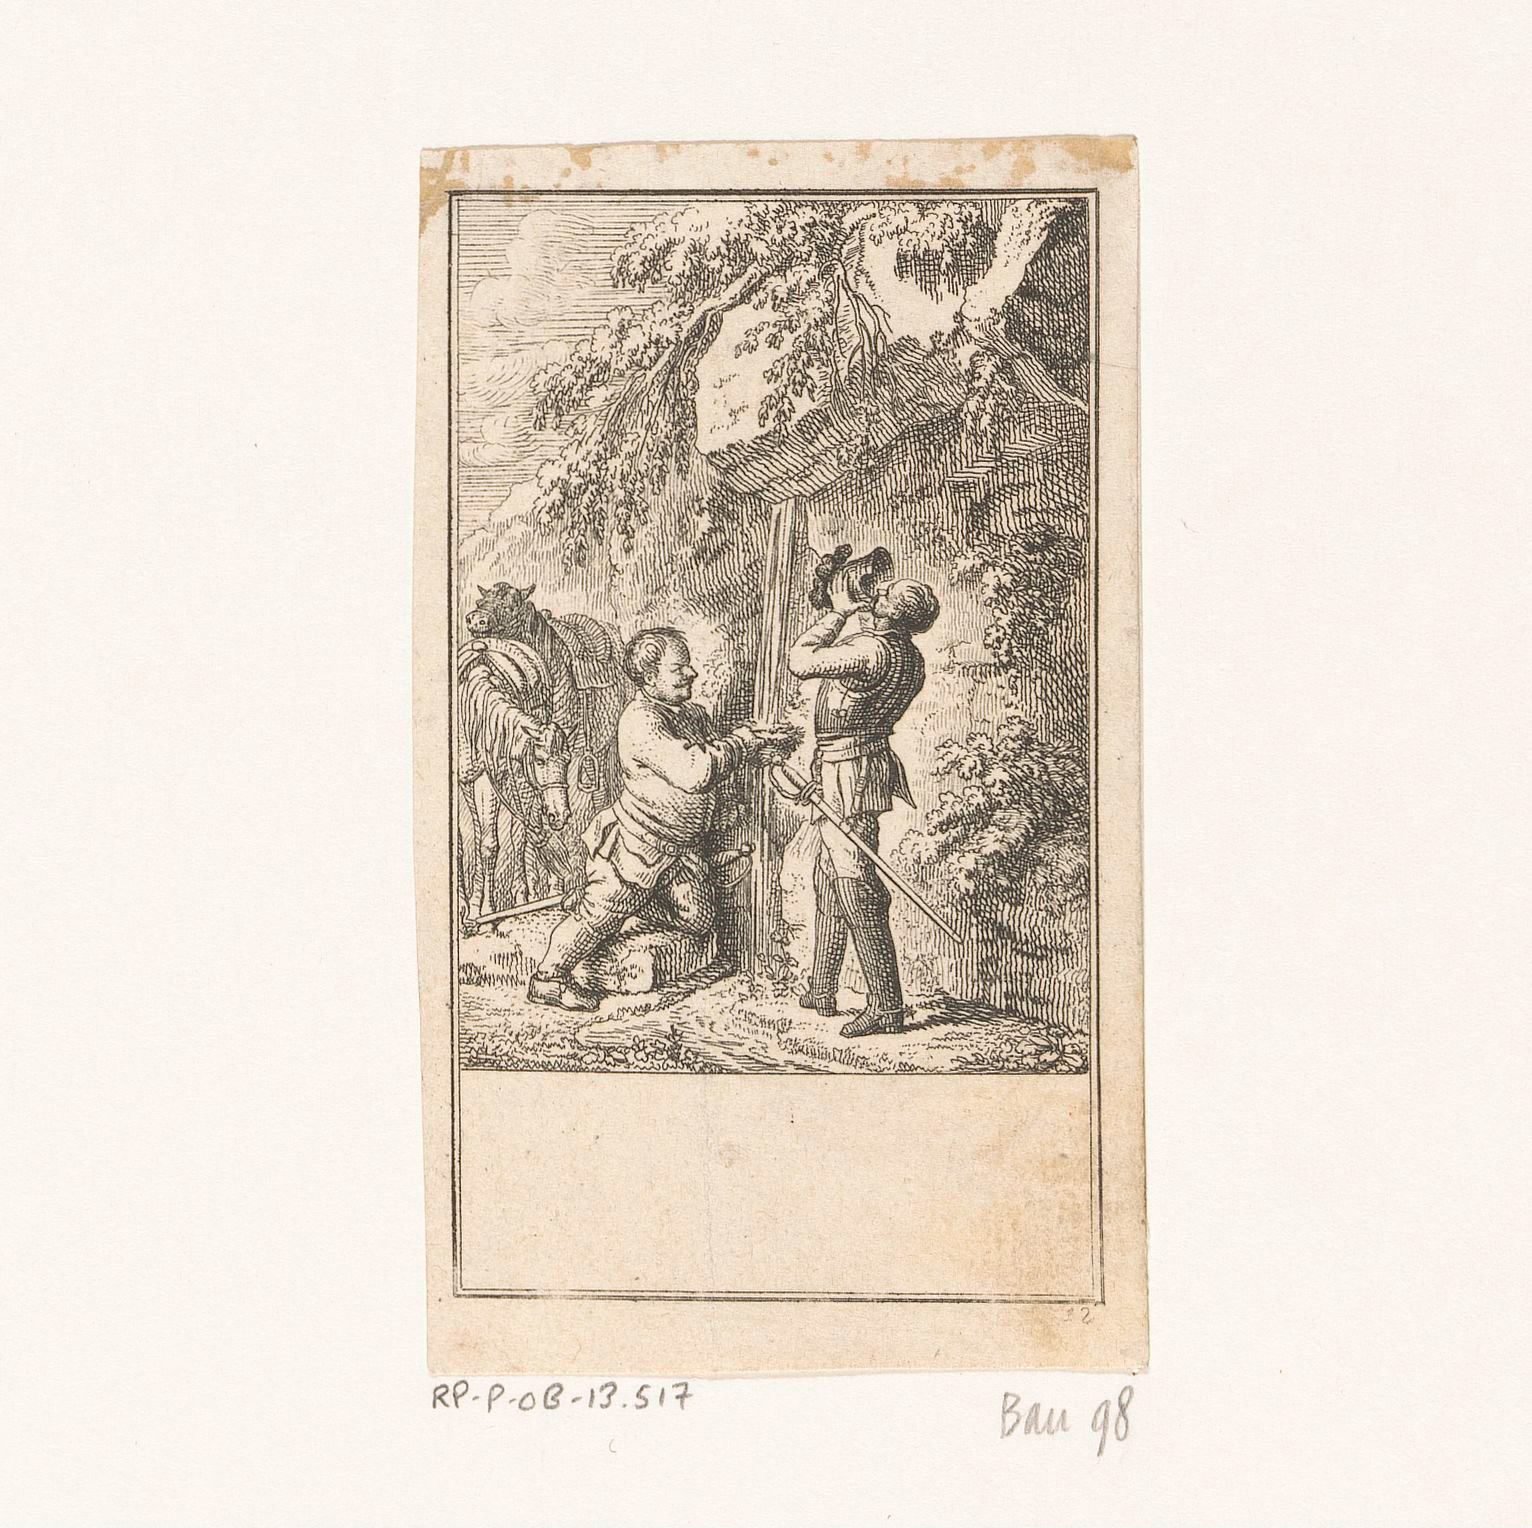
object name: print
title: Don Quichot en Sancho Panza drinken water uit een rots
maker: daniel nikolaus chodowiecki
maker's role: draughtsman, print maker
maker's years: 1726-1801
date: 1770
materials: paper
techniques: etching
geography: berlin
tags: don quixote, sancho panza, drinking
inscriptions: collector's mark: Lugt 240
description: Deze prent maakt deel uit van een serie van twaalf scènes die het verhaal van Don Quichot door Miguel de Cervantes Saavedra illustreren. De scènes werden op een plaat geëtst. De tweede staat van deze serie werd ook gebruikt in: 'Almanac Genealogique pour l'an 1771'.